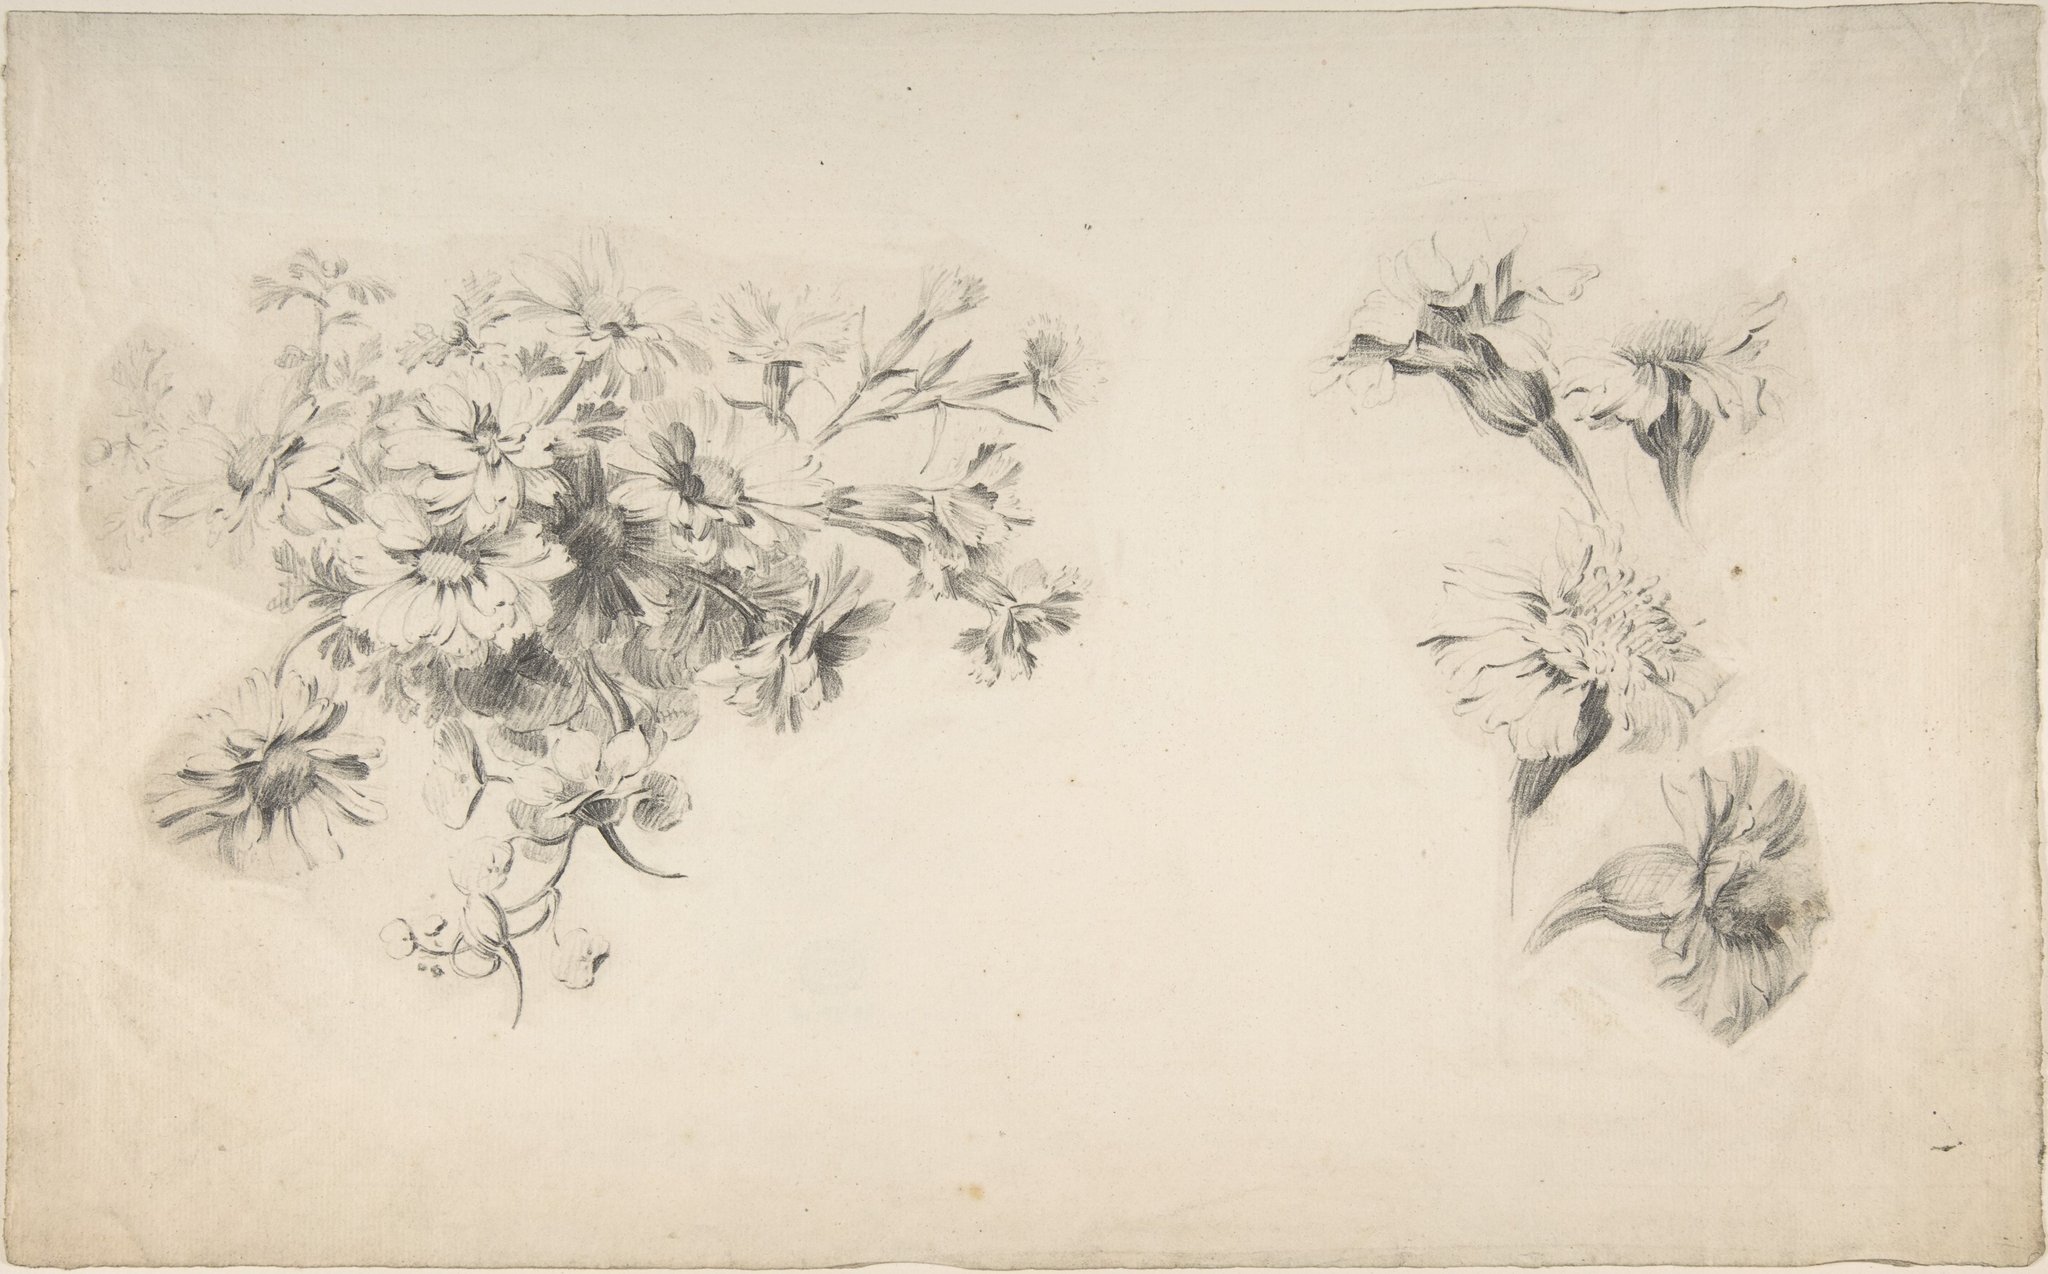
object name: drawing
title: Studies of Flowers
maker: anonymous, french, 18th century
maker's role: artist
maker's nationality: french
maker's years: 1700-1800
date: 1701-1800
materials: graphite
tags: flowers